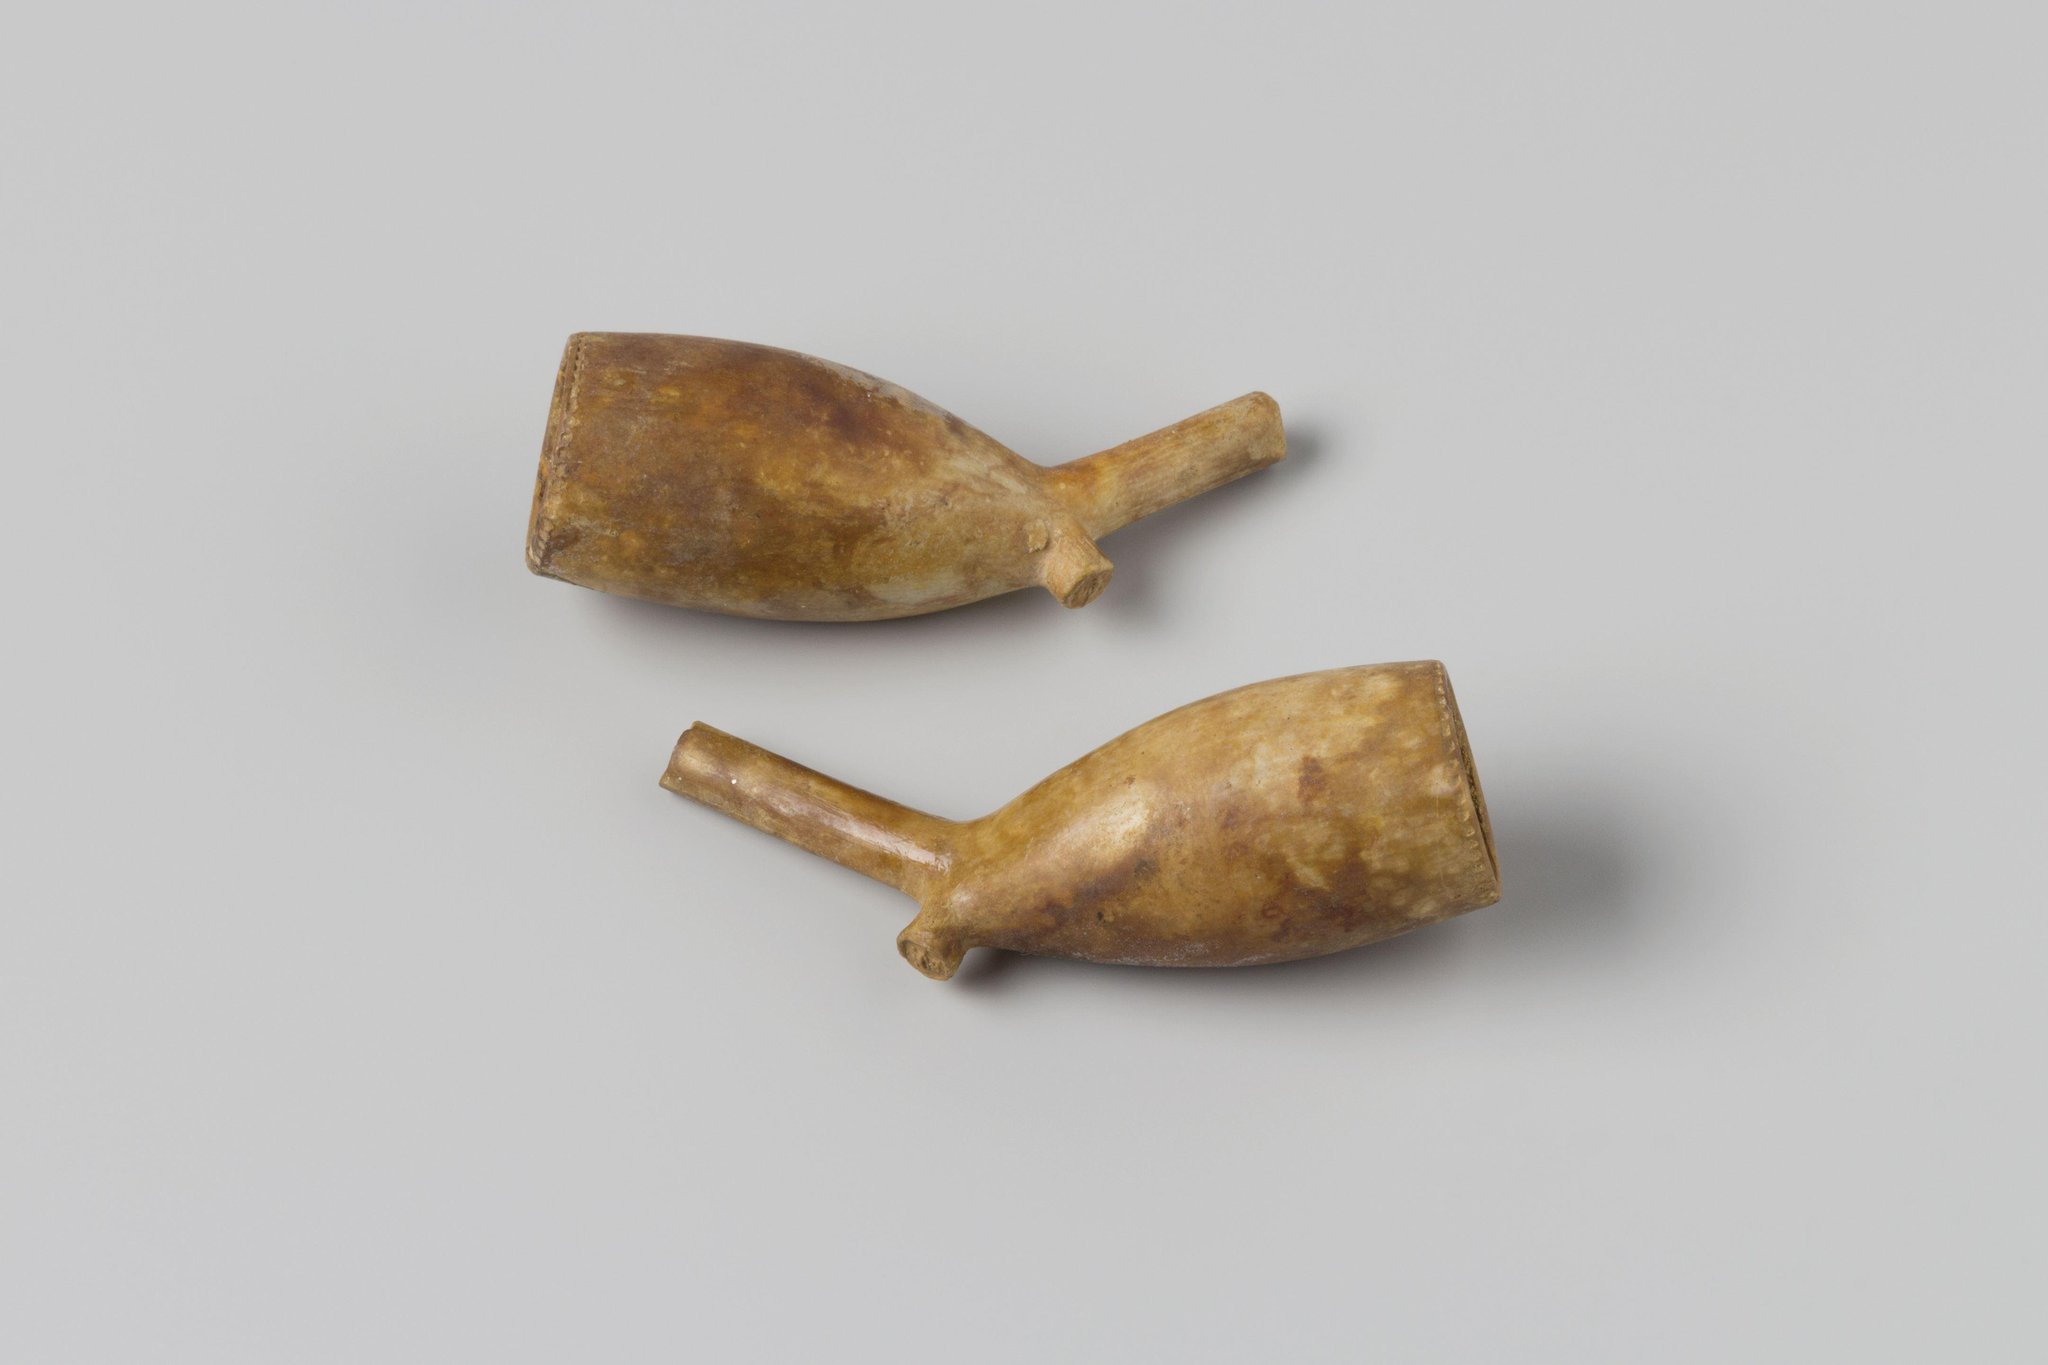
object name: pipe bowl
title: Pijpenkoppen met stuk steel uit het wrak van de Oost-Indiëvaarder Hollandia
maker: Anonymous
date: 1700-1743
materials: clay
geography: netherlands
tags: verenigde oostindische compagnie, hollandia (schip), annet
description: Pipe, bowl, heelmark: tobacco's brazier; 2hsm2.